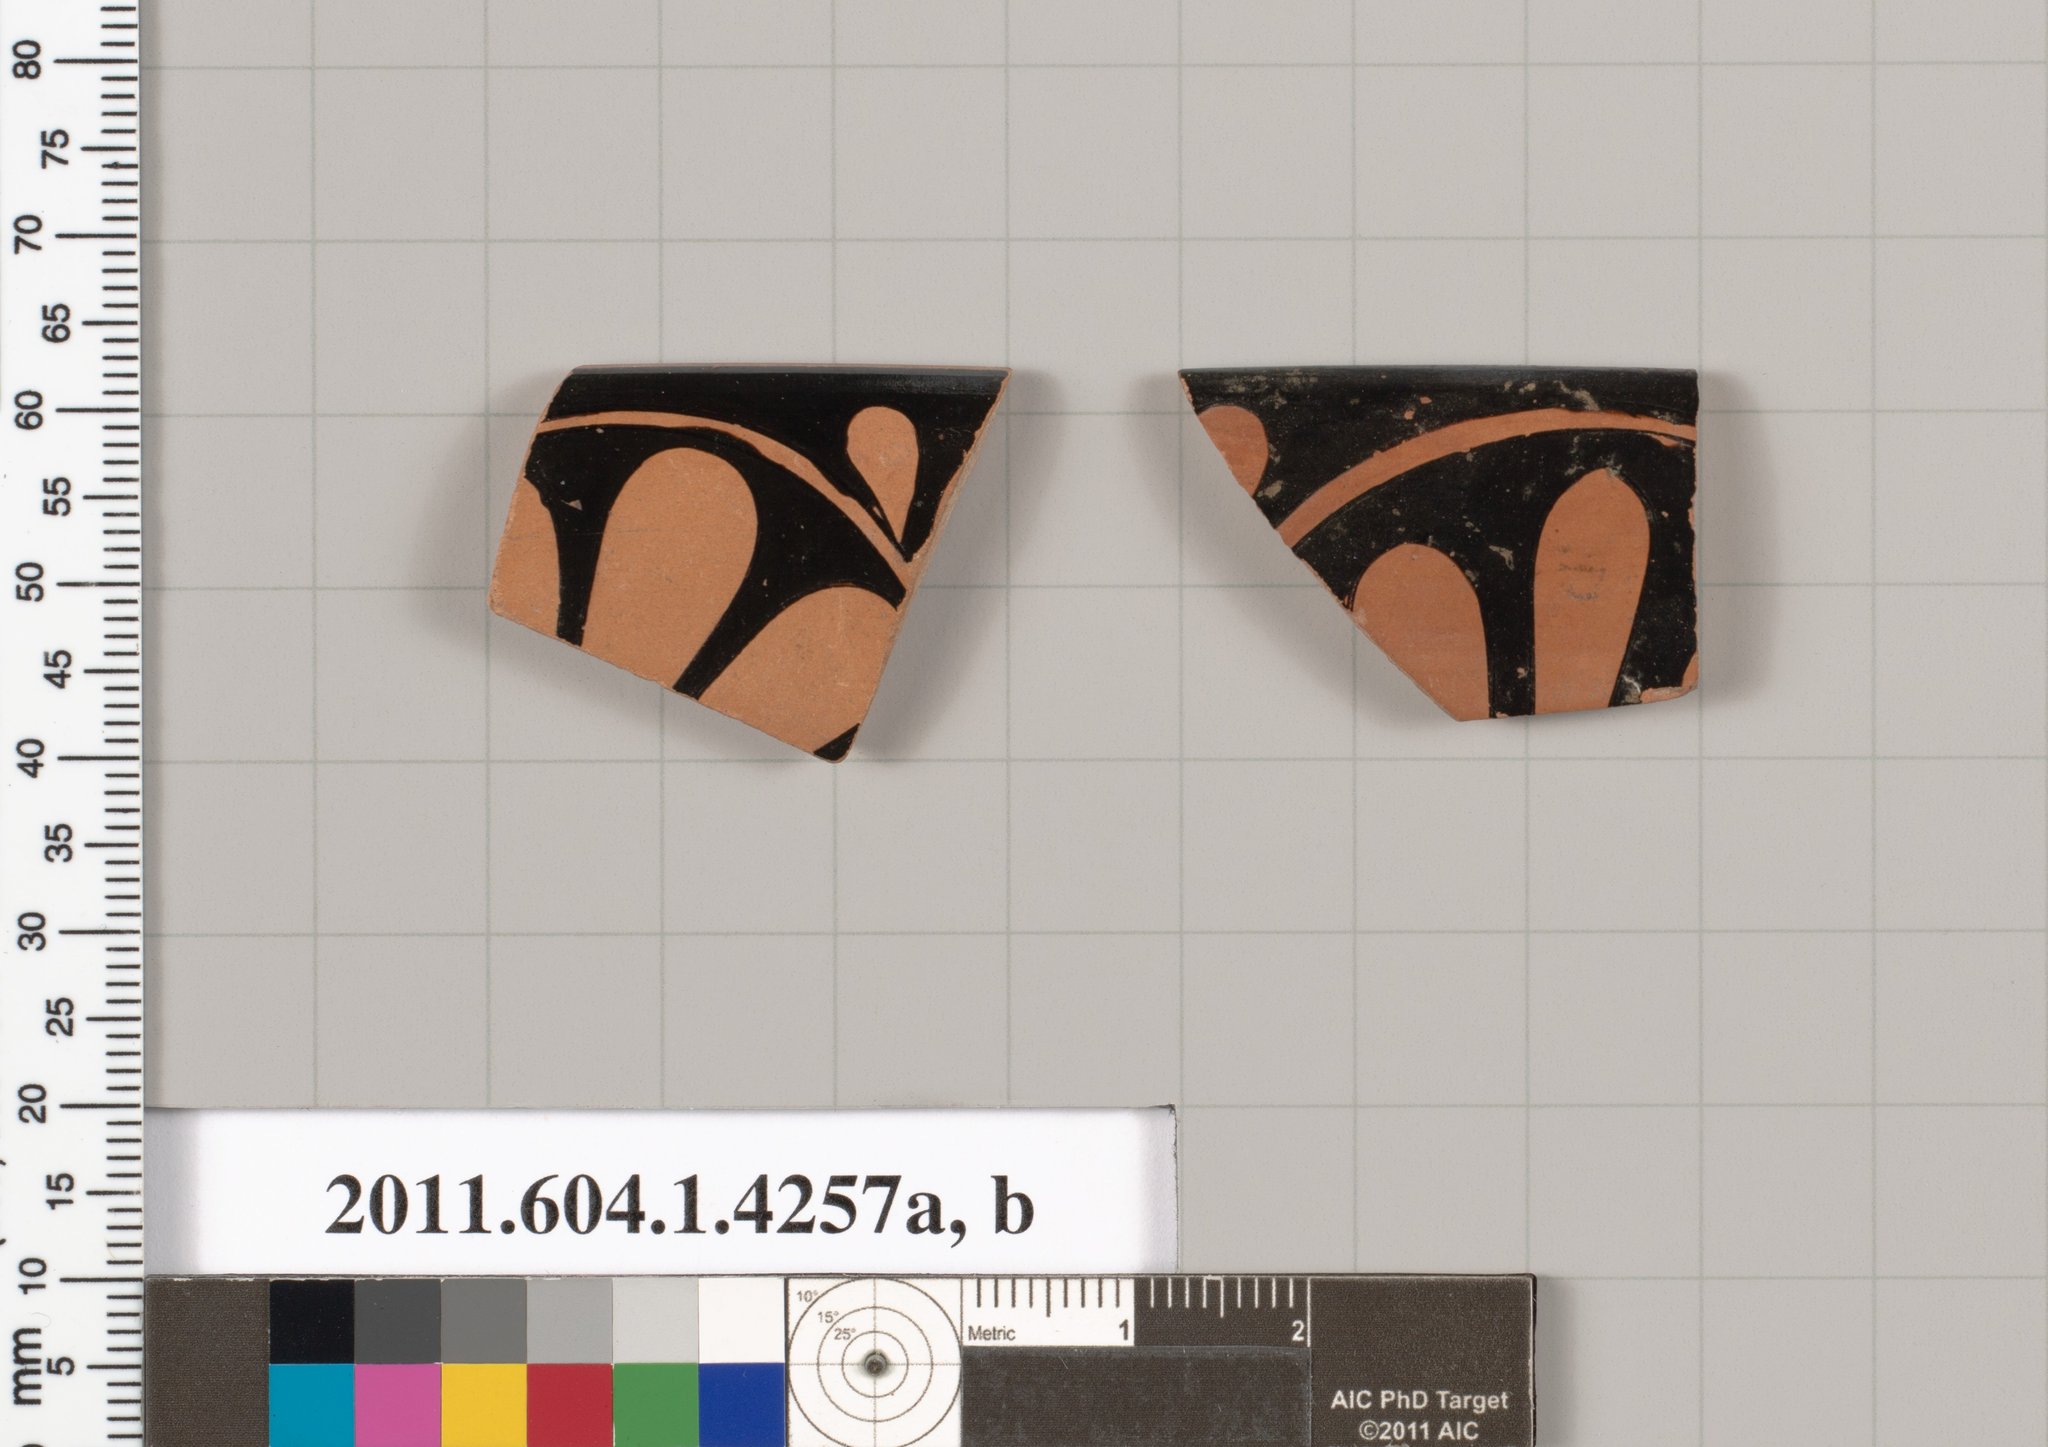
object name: kylix fragment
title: Terracotta rim fragments of kylikes (drinking cups)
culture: greek, attic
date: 520-500 BCE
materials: terracotta